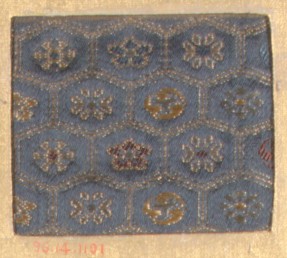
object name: piece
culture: japanese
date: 1701-1900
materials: silk